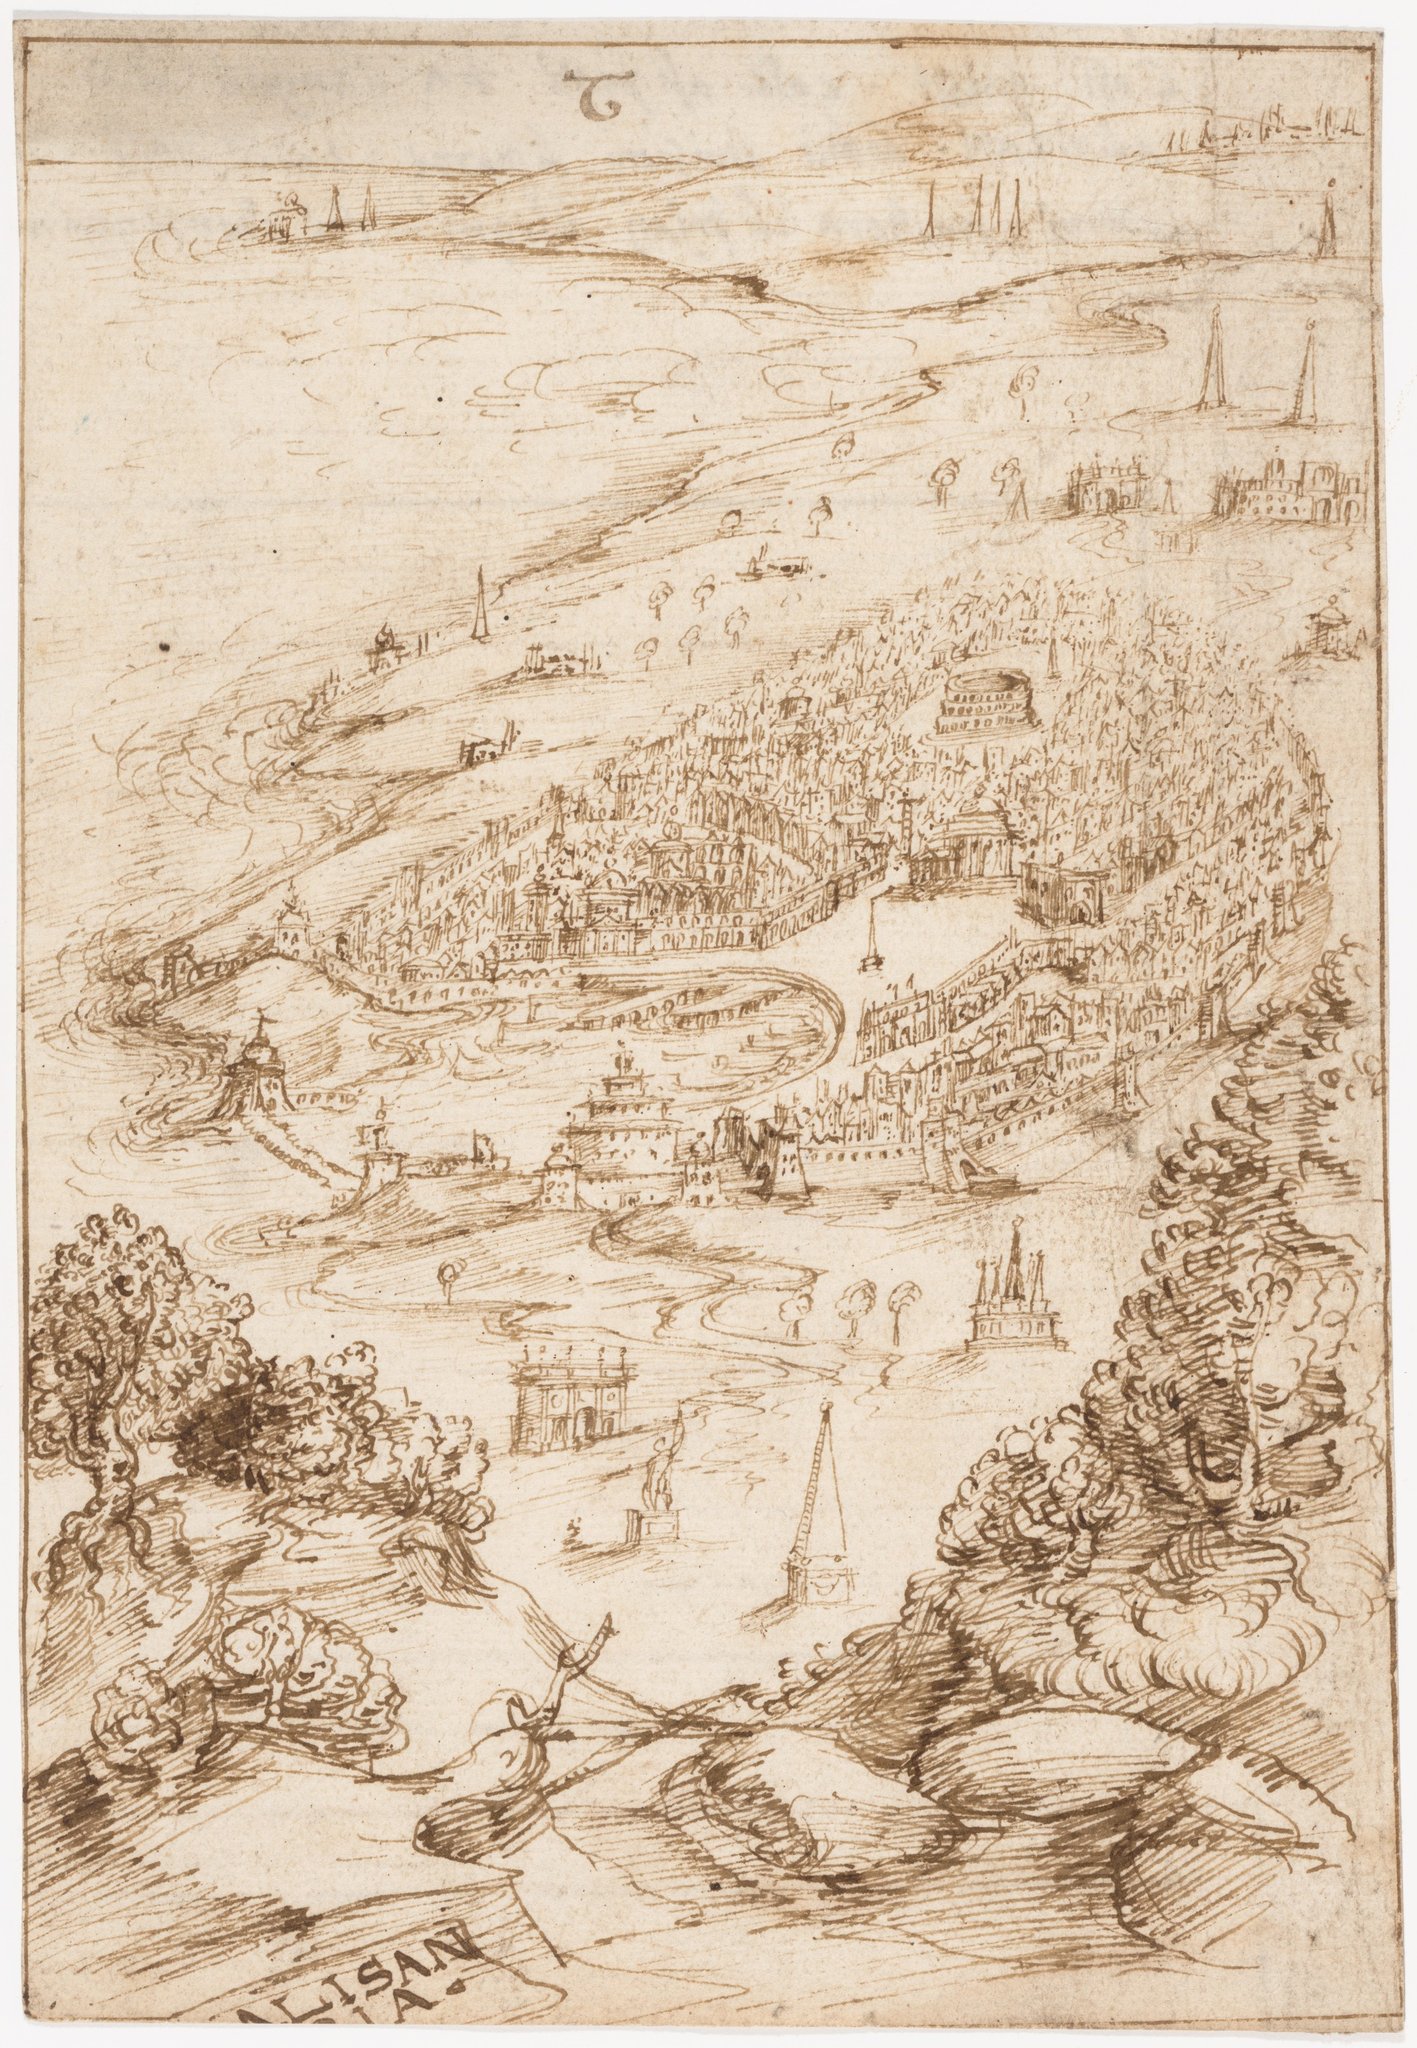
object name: drawing ornament architecture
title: Recto: The Port City of Alexandria (? Allusion to Dinocrates's Building of Alexandria, Vitruvius, Book 2, introduction, no. 1); Verso: Fragmentary Writing ("Libro Primo...").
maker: sangallo family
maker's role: artist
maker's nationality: italian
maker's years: 1530-1545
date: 1530-1545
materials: ink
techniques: pen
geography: france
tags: cities